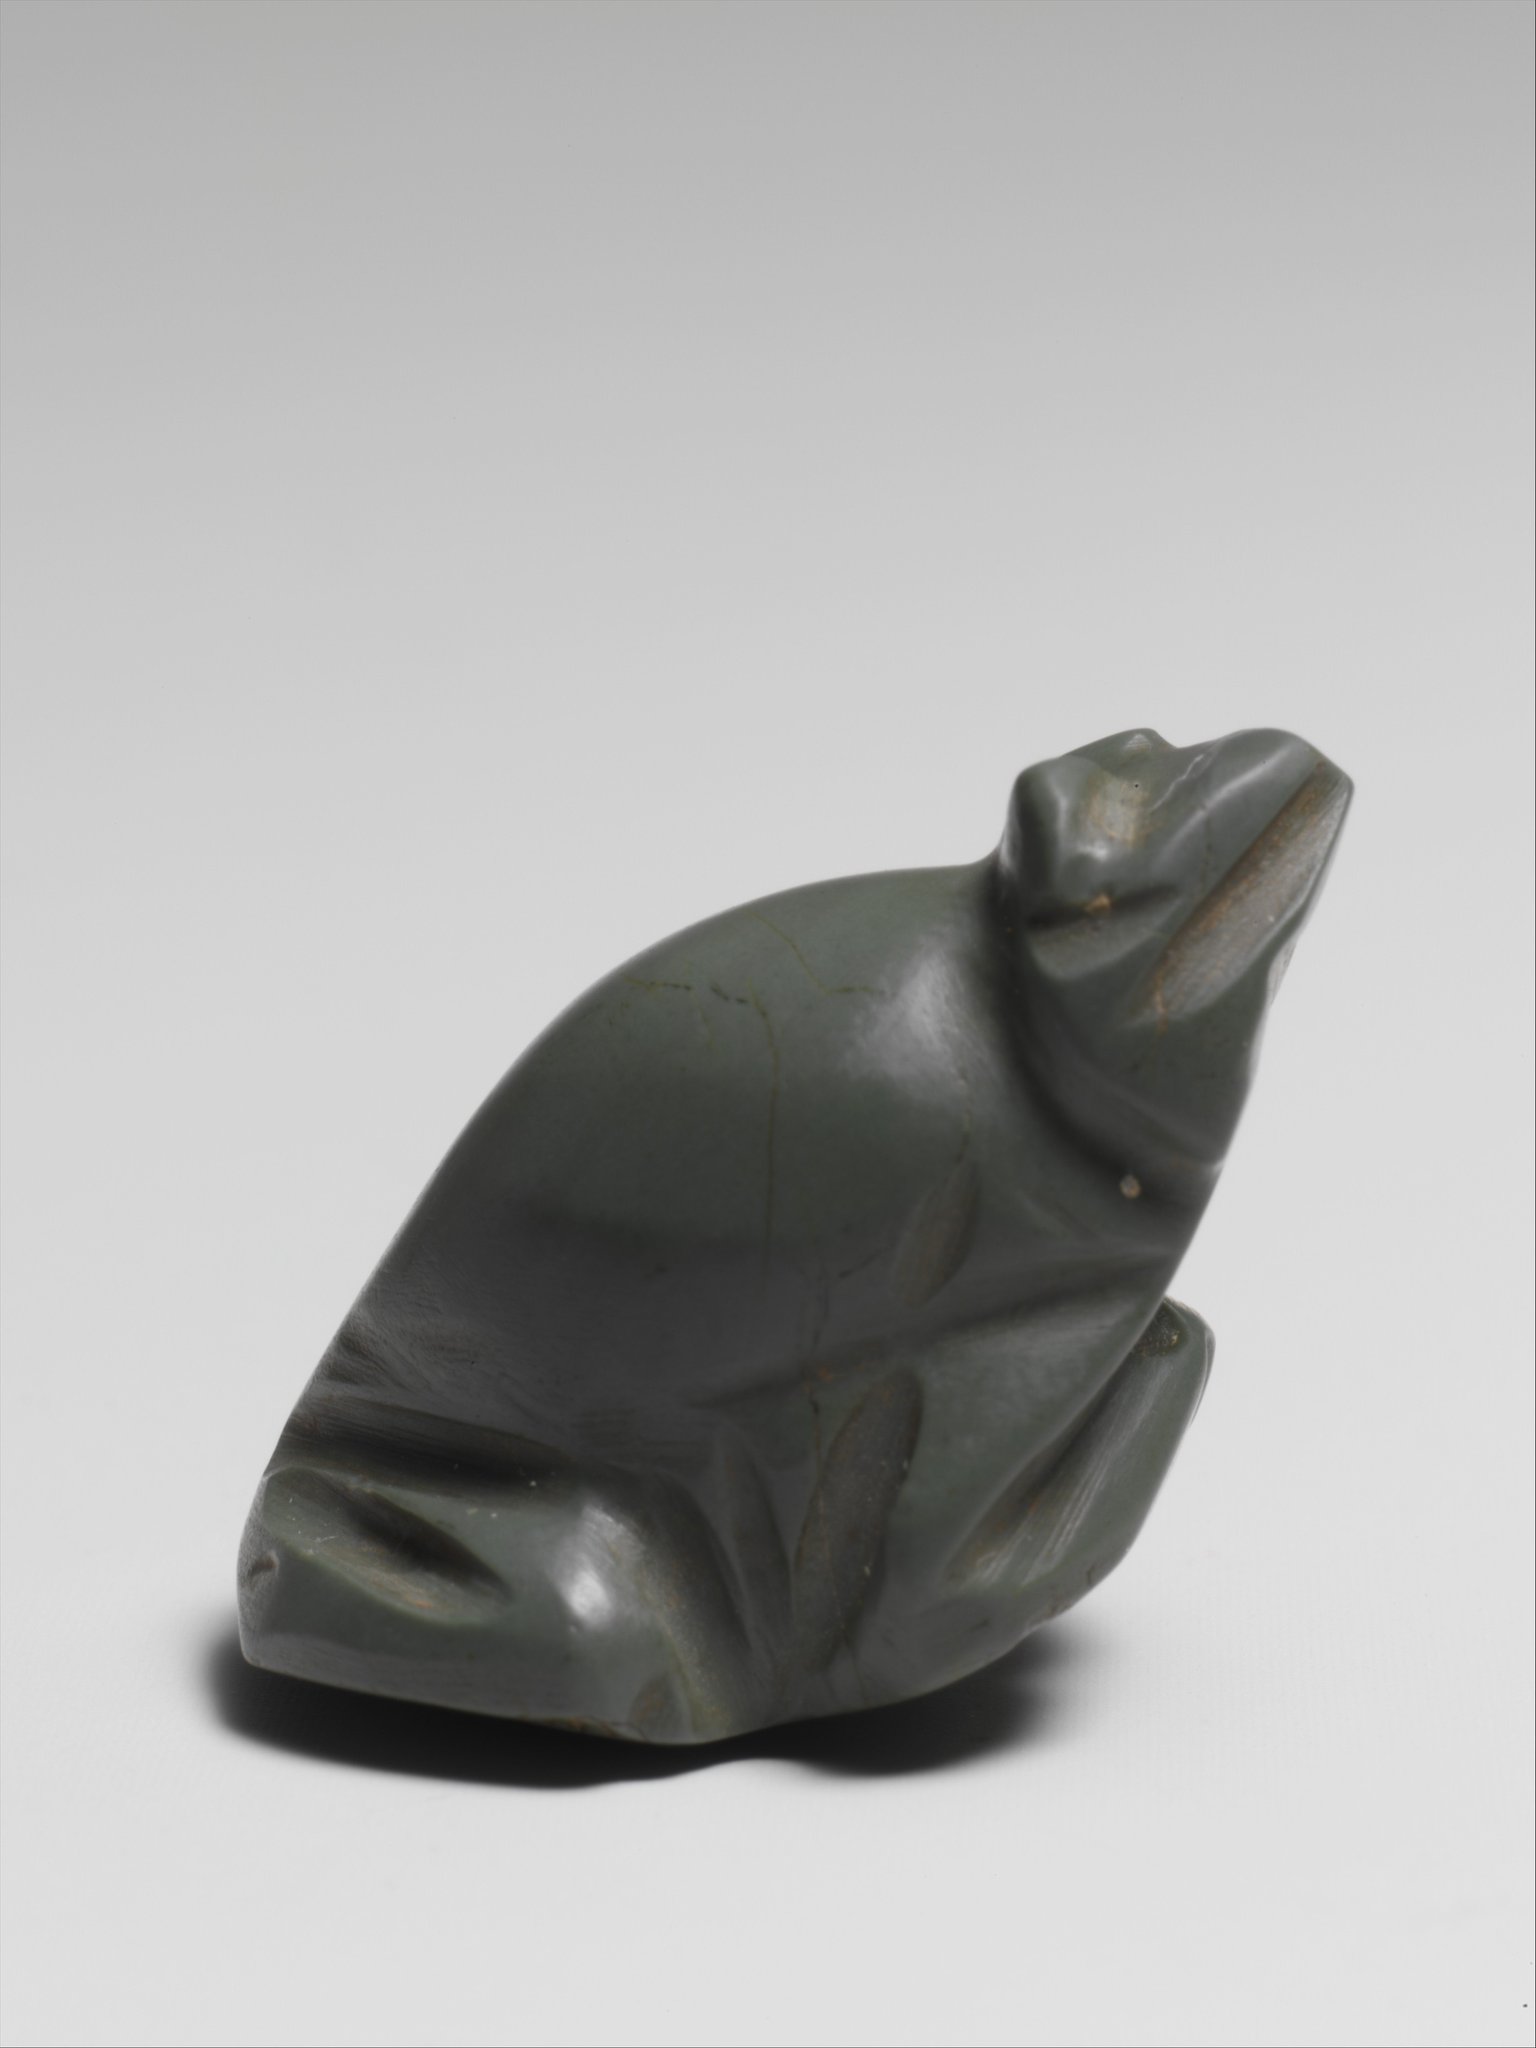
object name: amulet pendant, frog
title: Jasper amulet in the form of a frog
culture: egyptian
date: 664-334 BCE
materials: jasper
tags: frogs